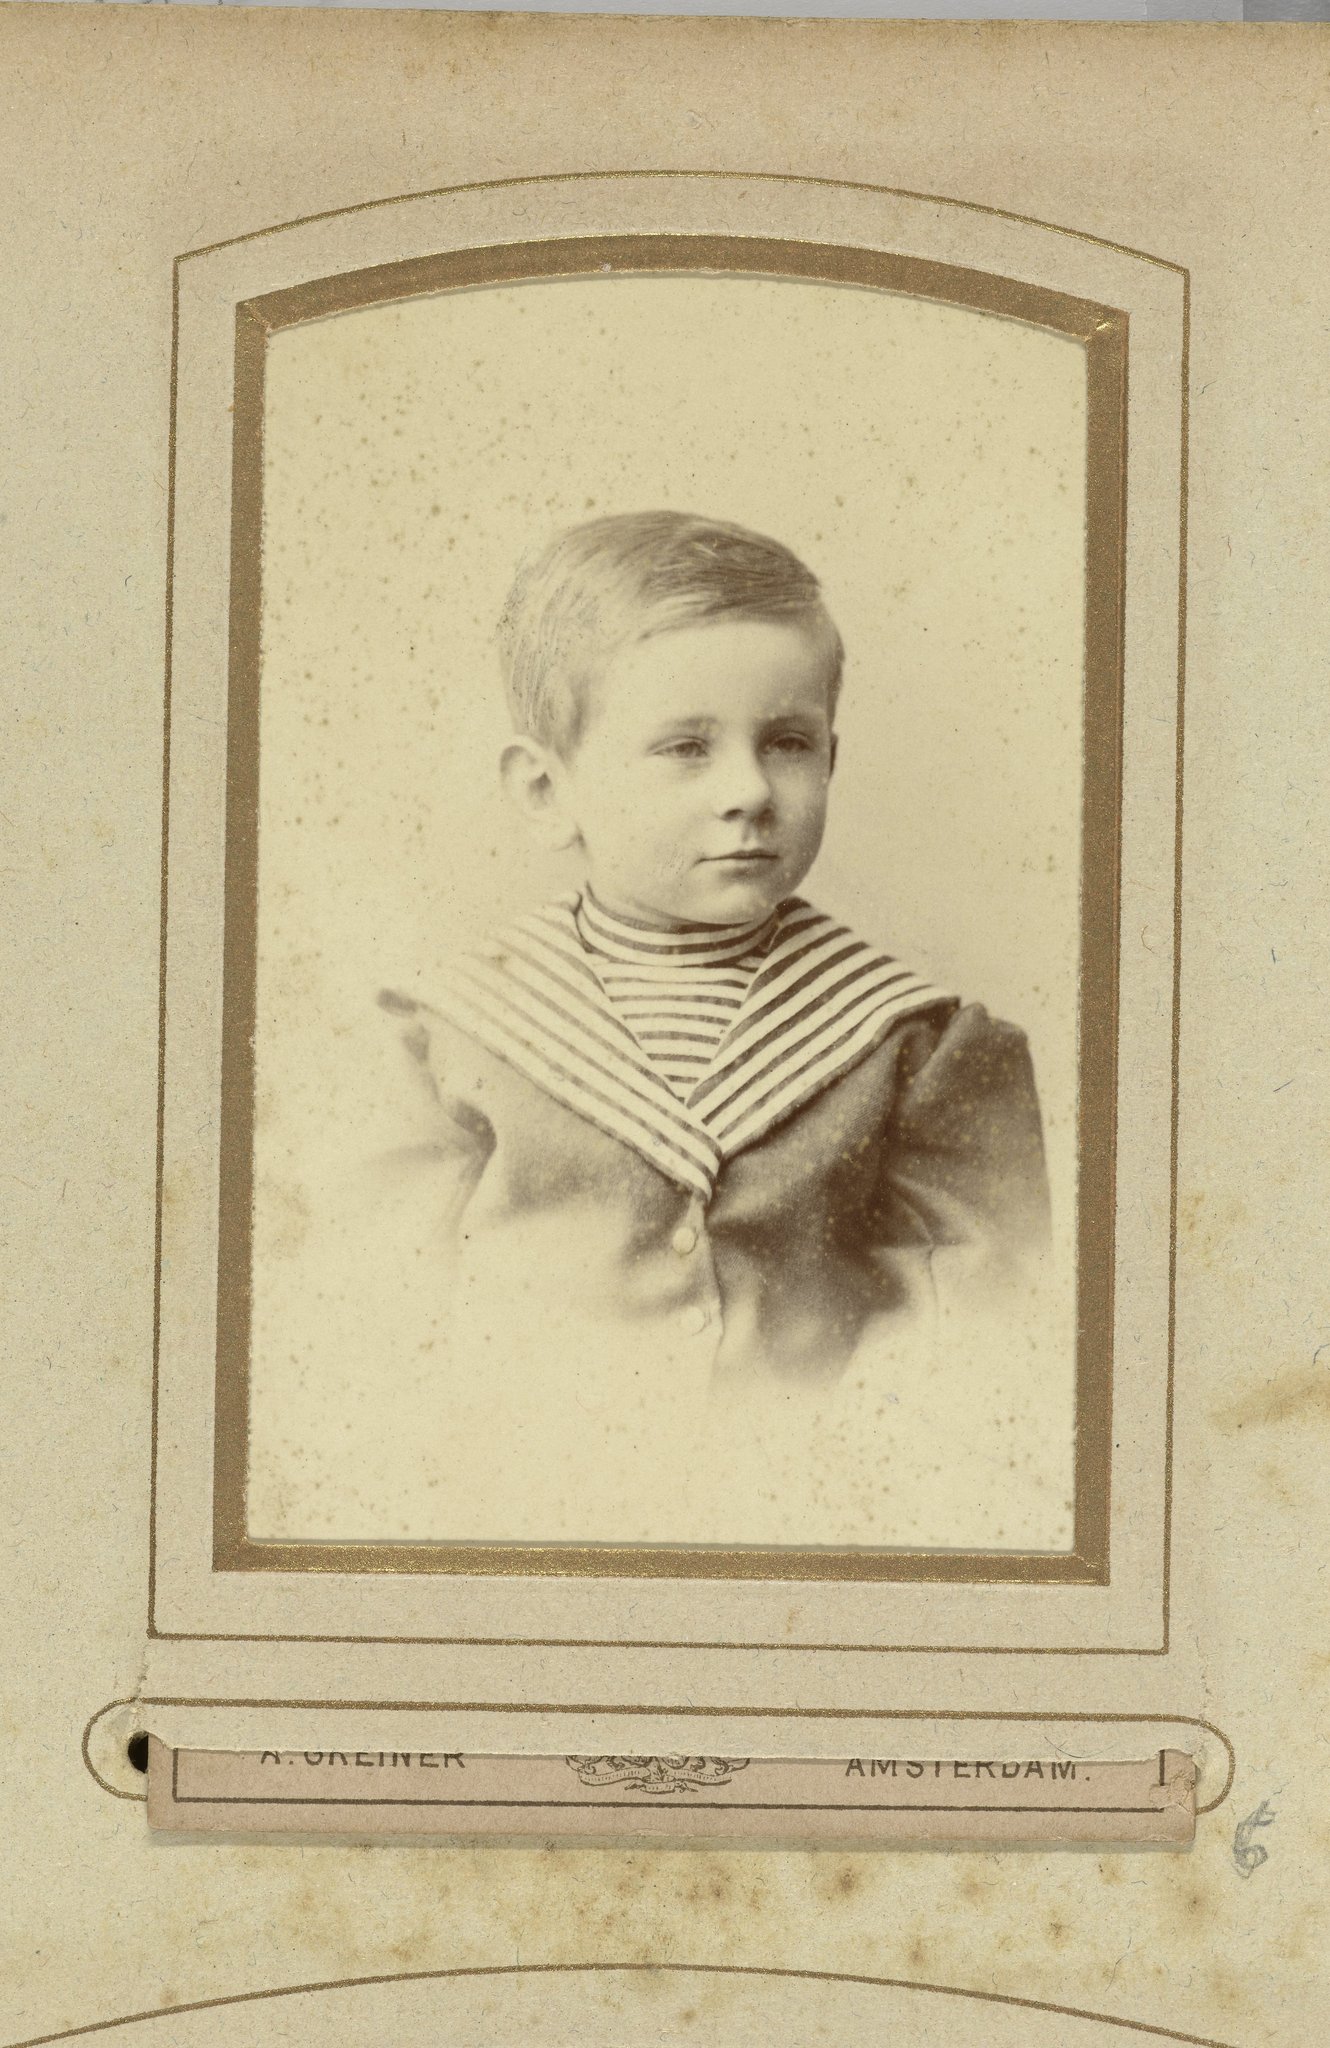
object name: carte de visite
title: Portret van Guus Kessler in matrozenpak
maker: albert greiner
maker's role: fotograaf, fotostudio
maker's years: 1833-1890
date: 1890-1910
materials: paper, photographic support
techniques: photography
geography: amsterdam